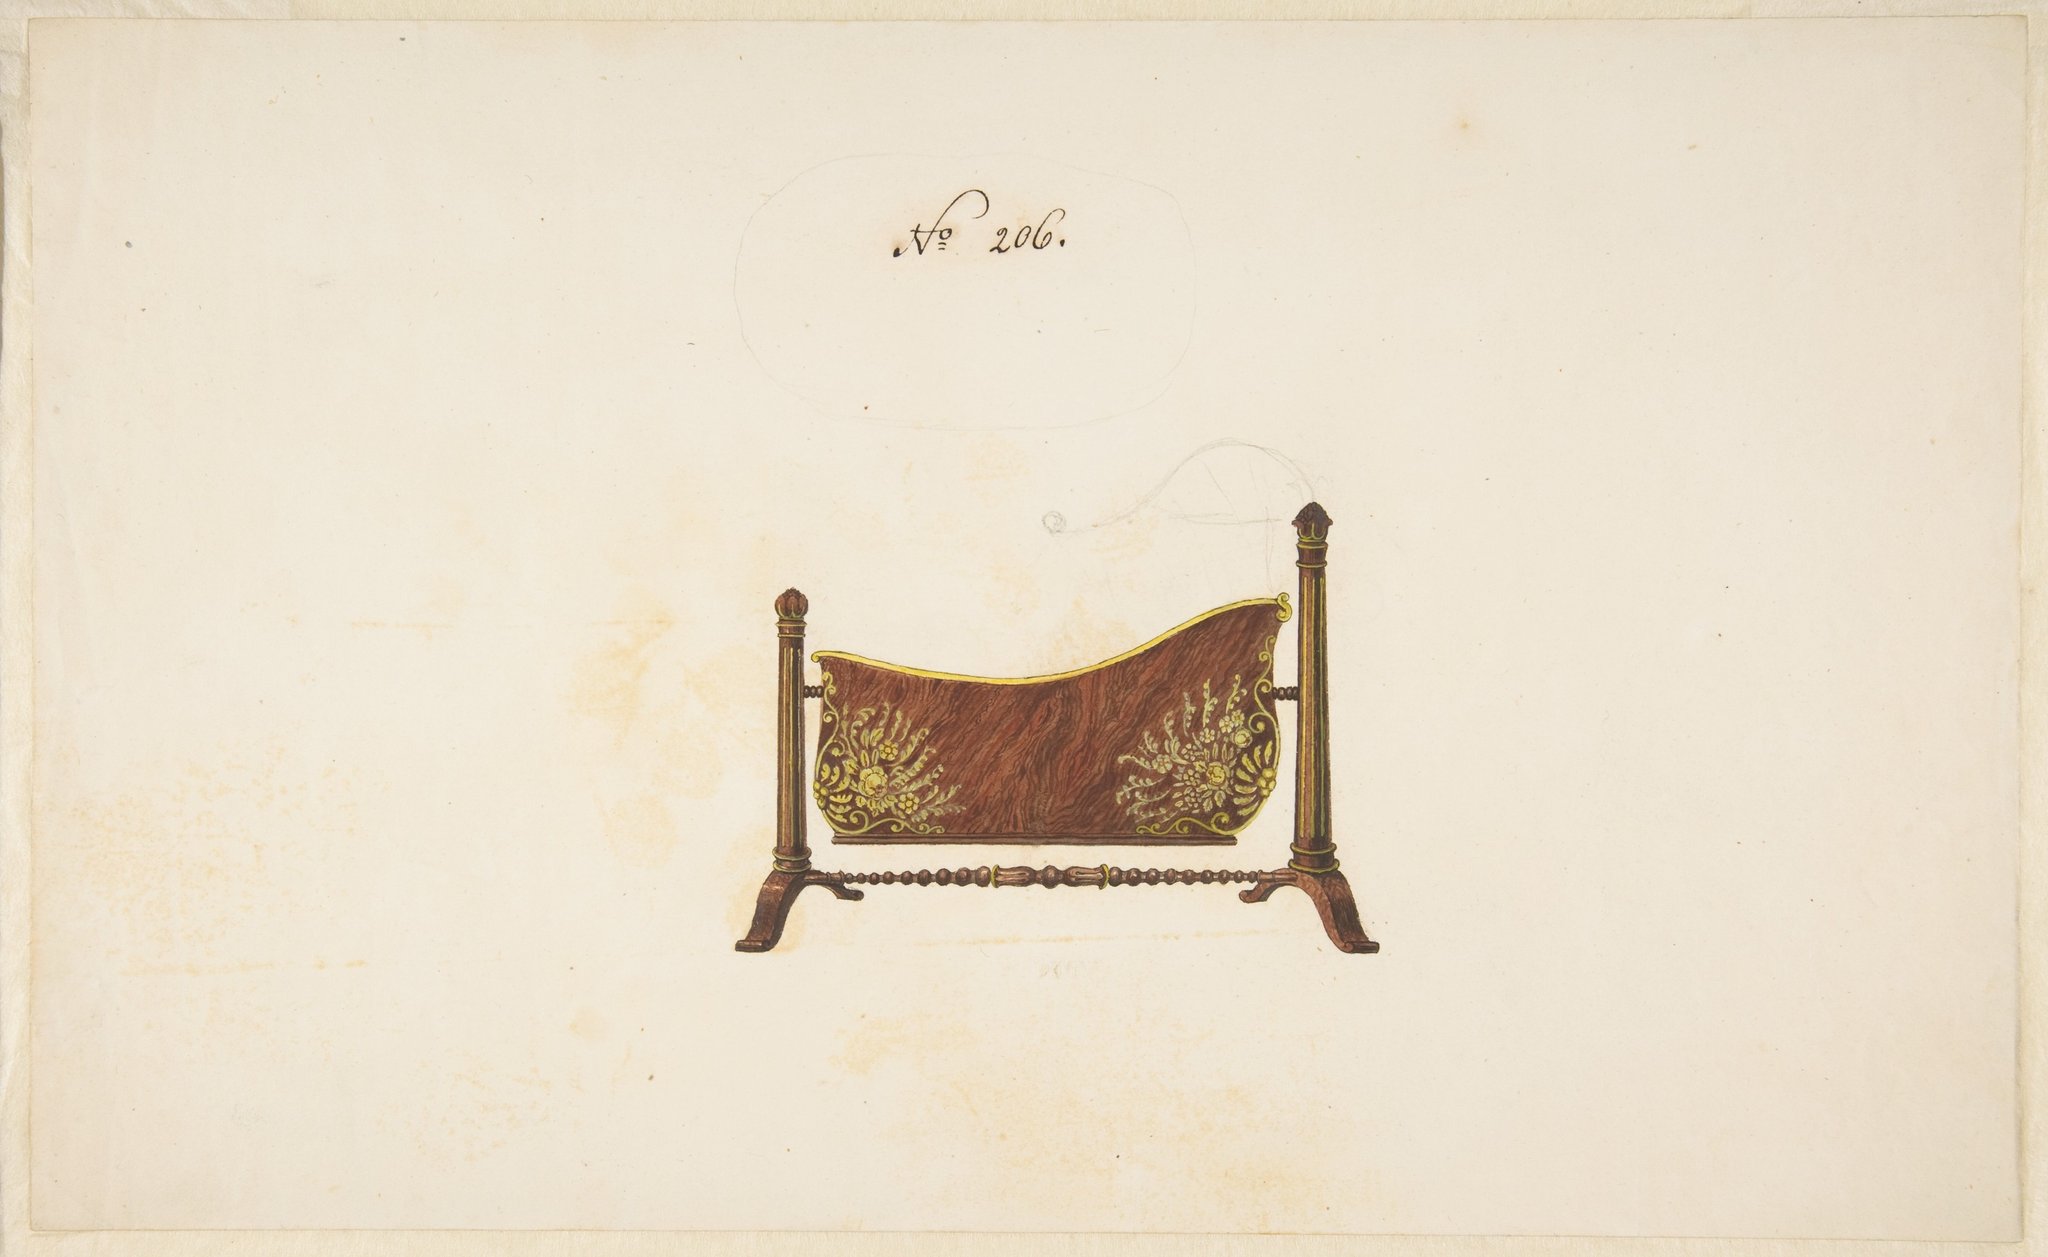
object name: drawing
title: Design for a Firescreen (?)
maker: anonymous, french, 19th century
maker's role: artist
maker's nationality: french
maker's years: 1800-1900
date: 1801-1900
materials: watercolor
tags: screens